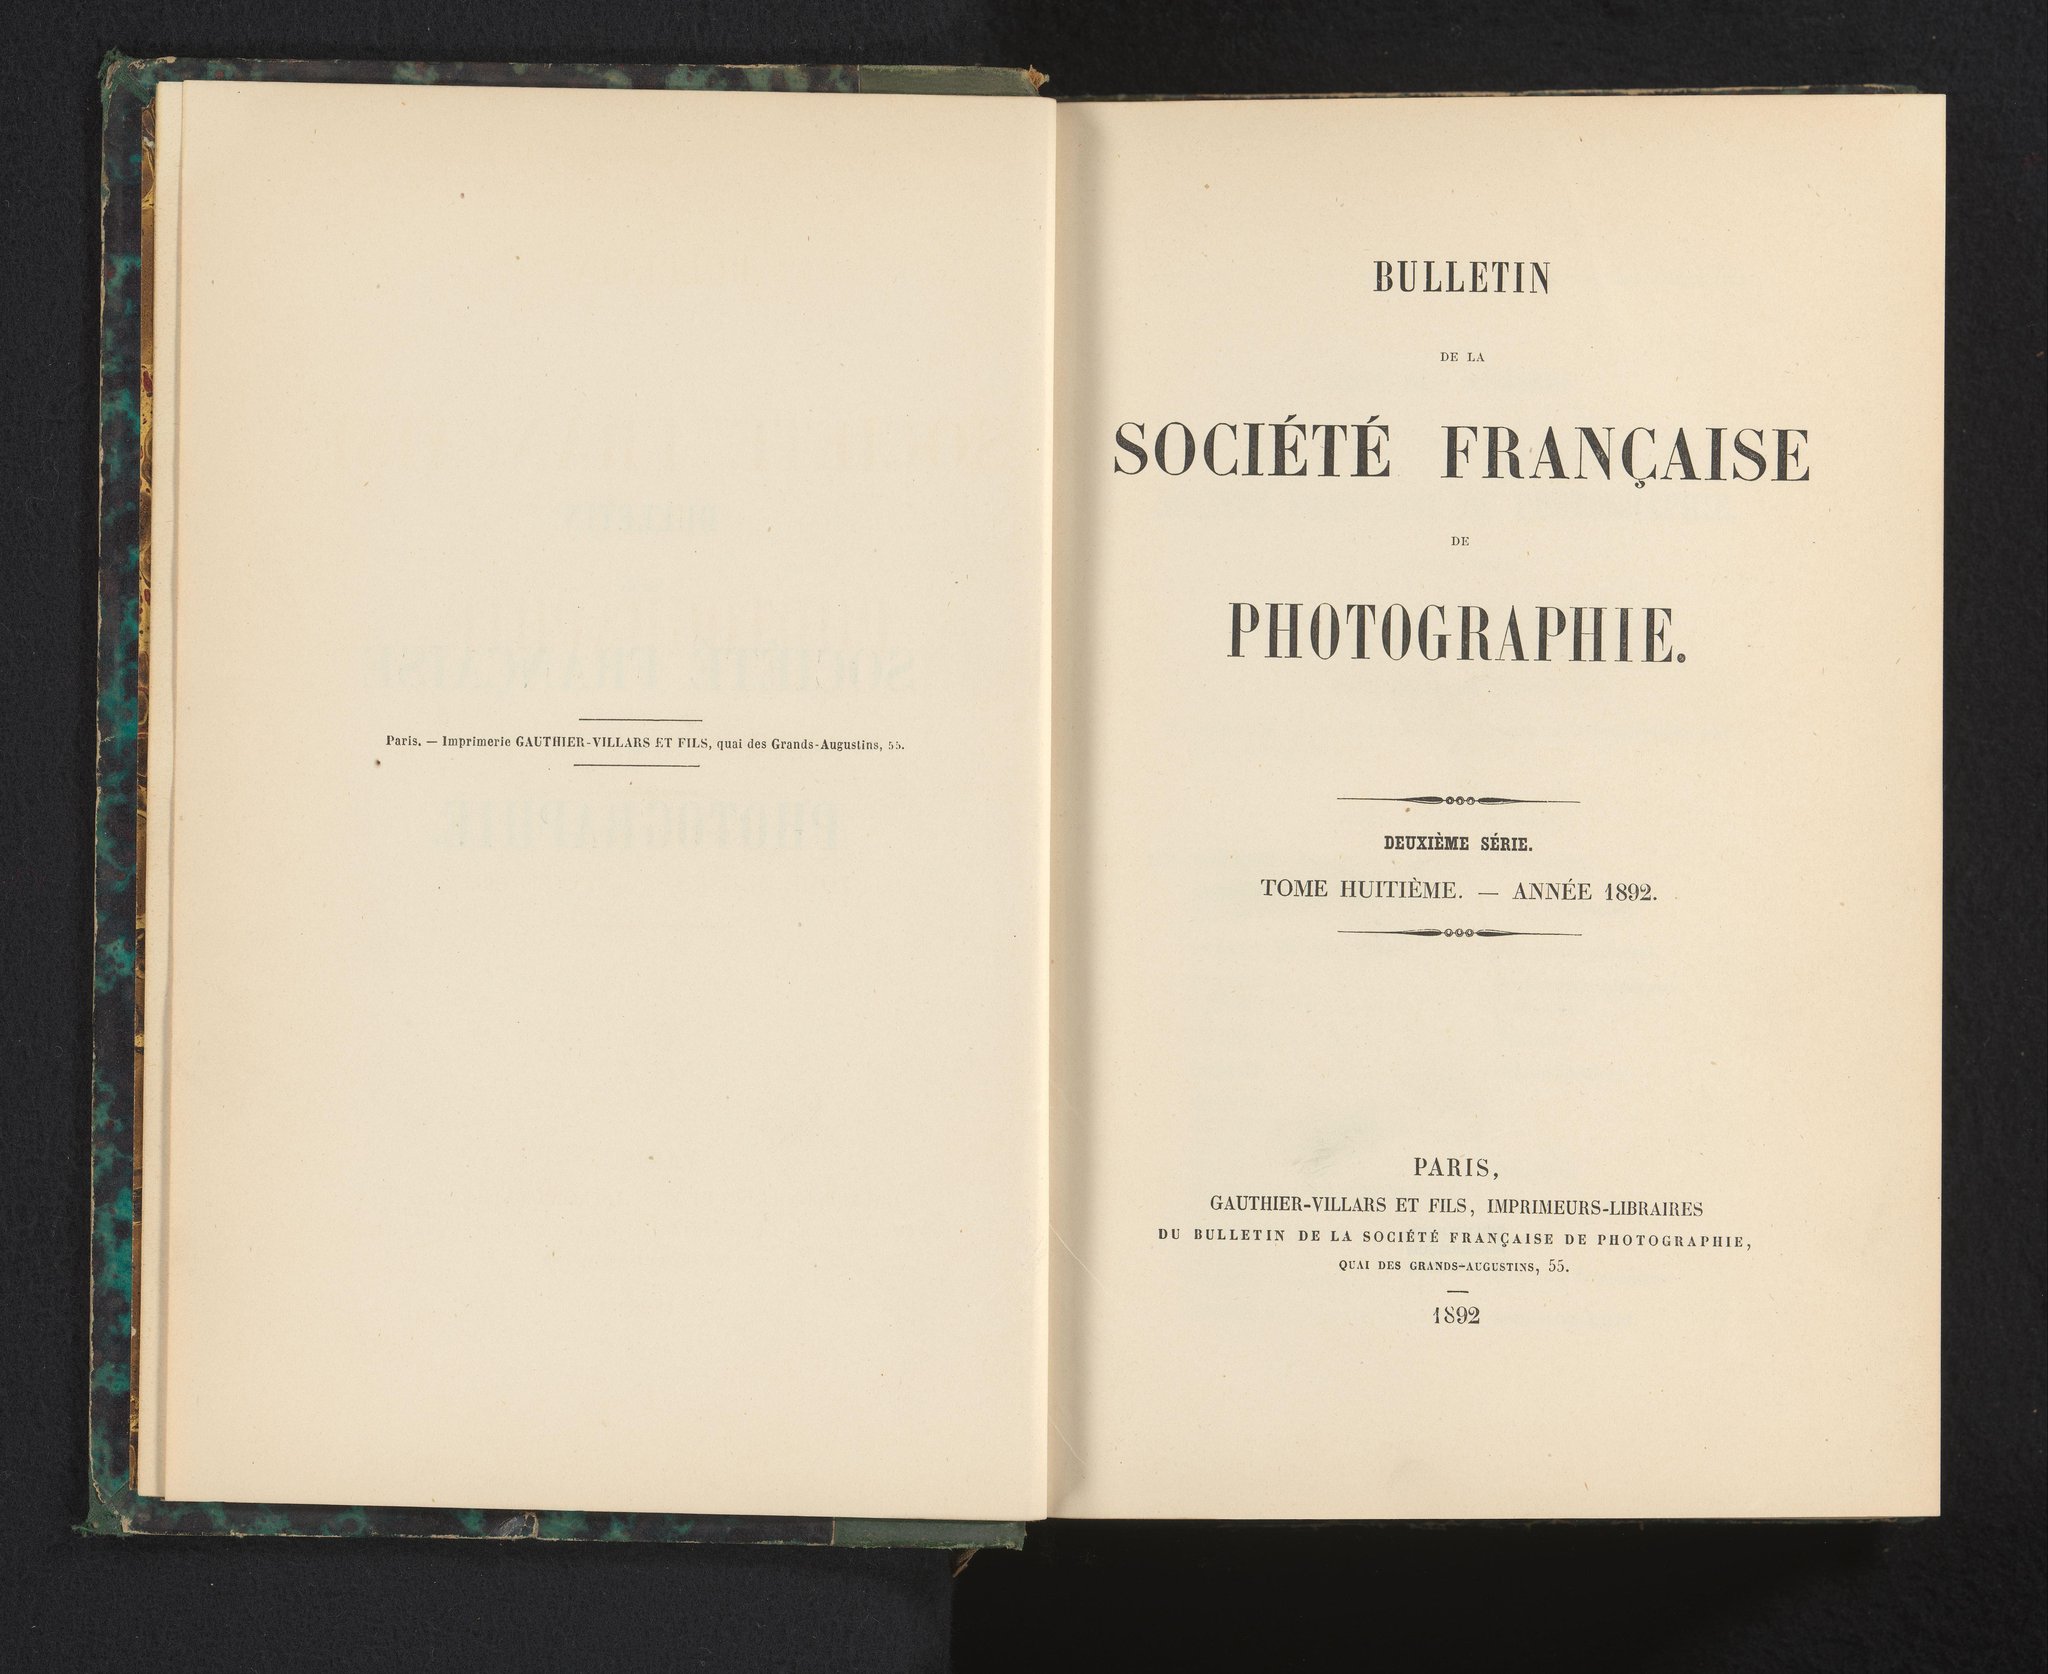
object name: book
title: Bulletin de la Société française de photographie. Deuxième série. Tome huitième - année 1892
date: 1892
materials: paper, cardboard, leather, textile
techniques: photograph, engraving, letterpress printing, marbling, photoaquatint, marbled paper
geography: paris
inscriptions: number: ‘858’